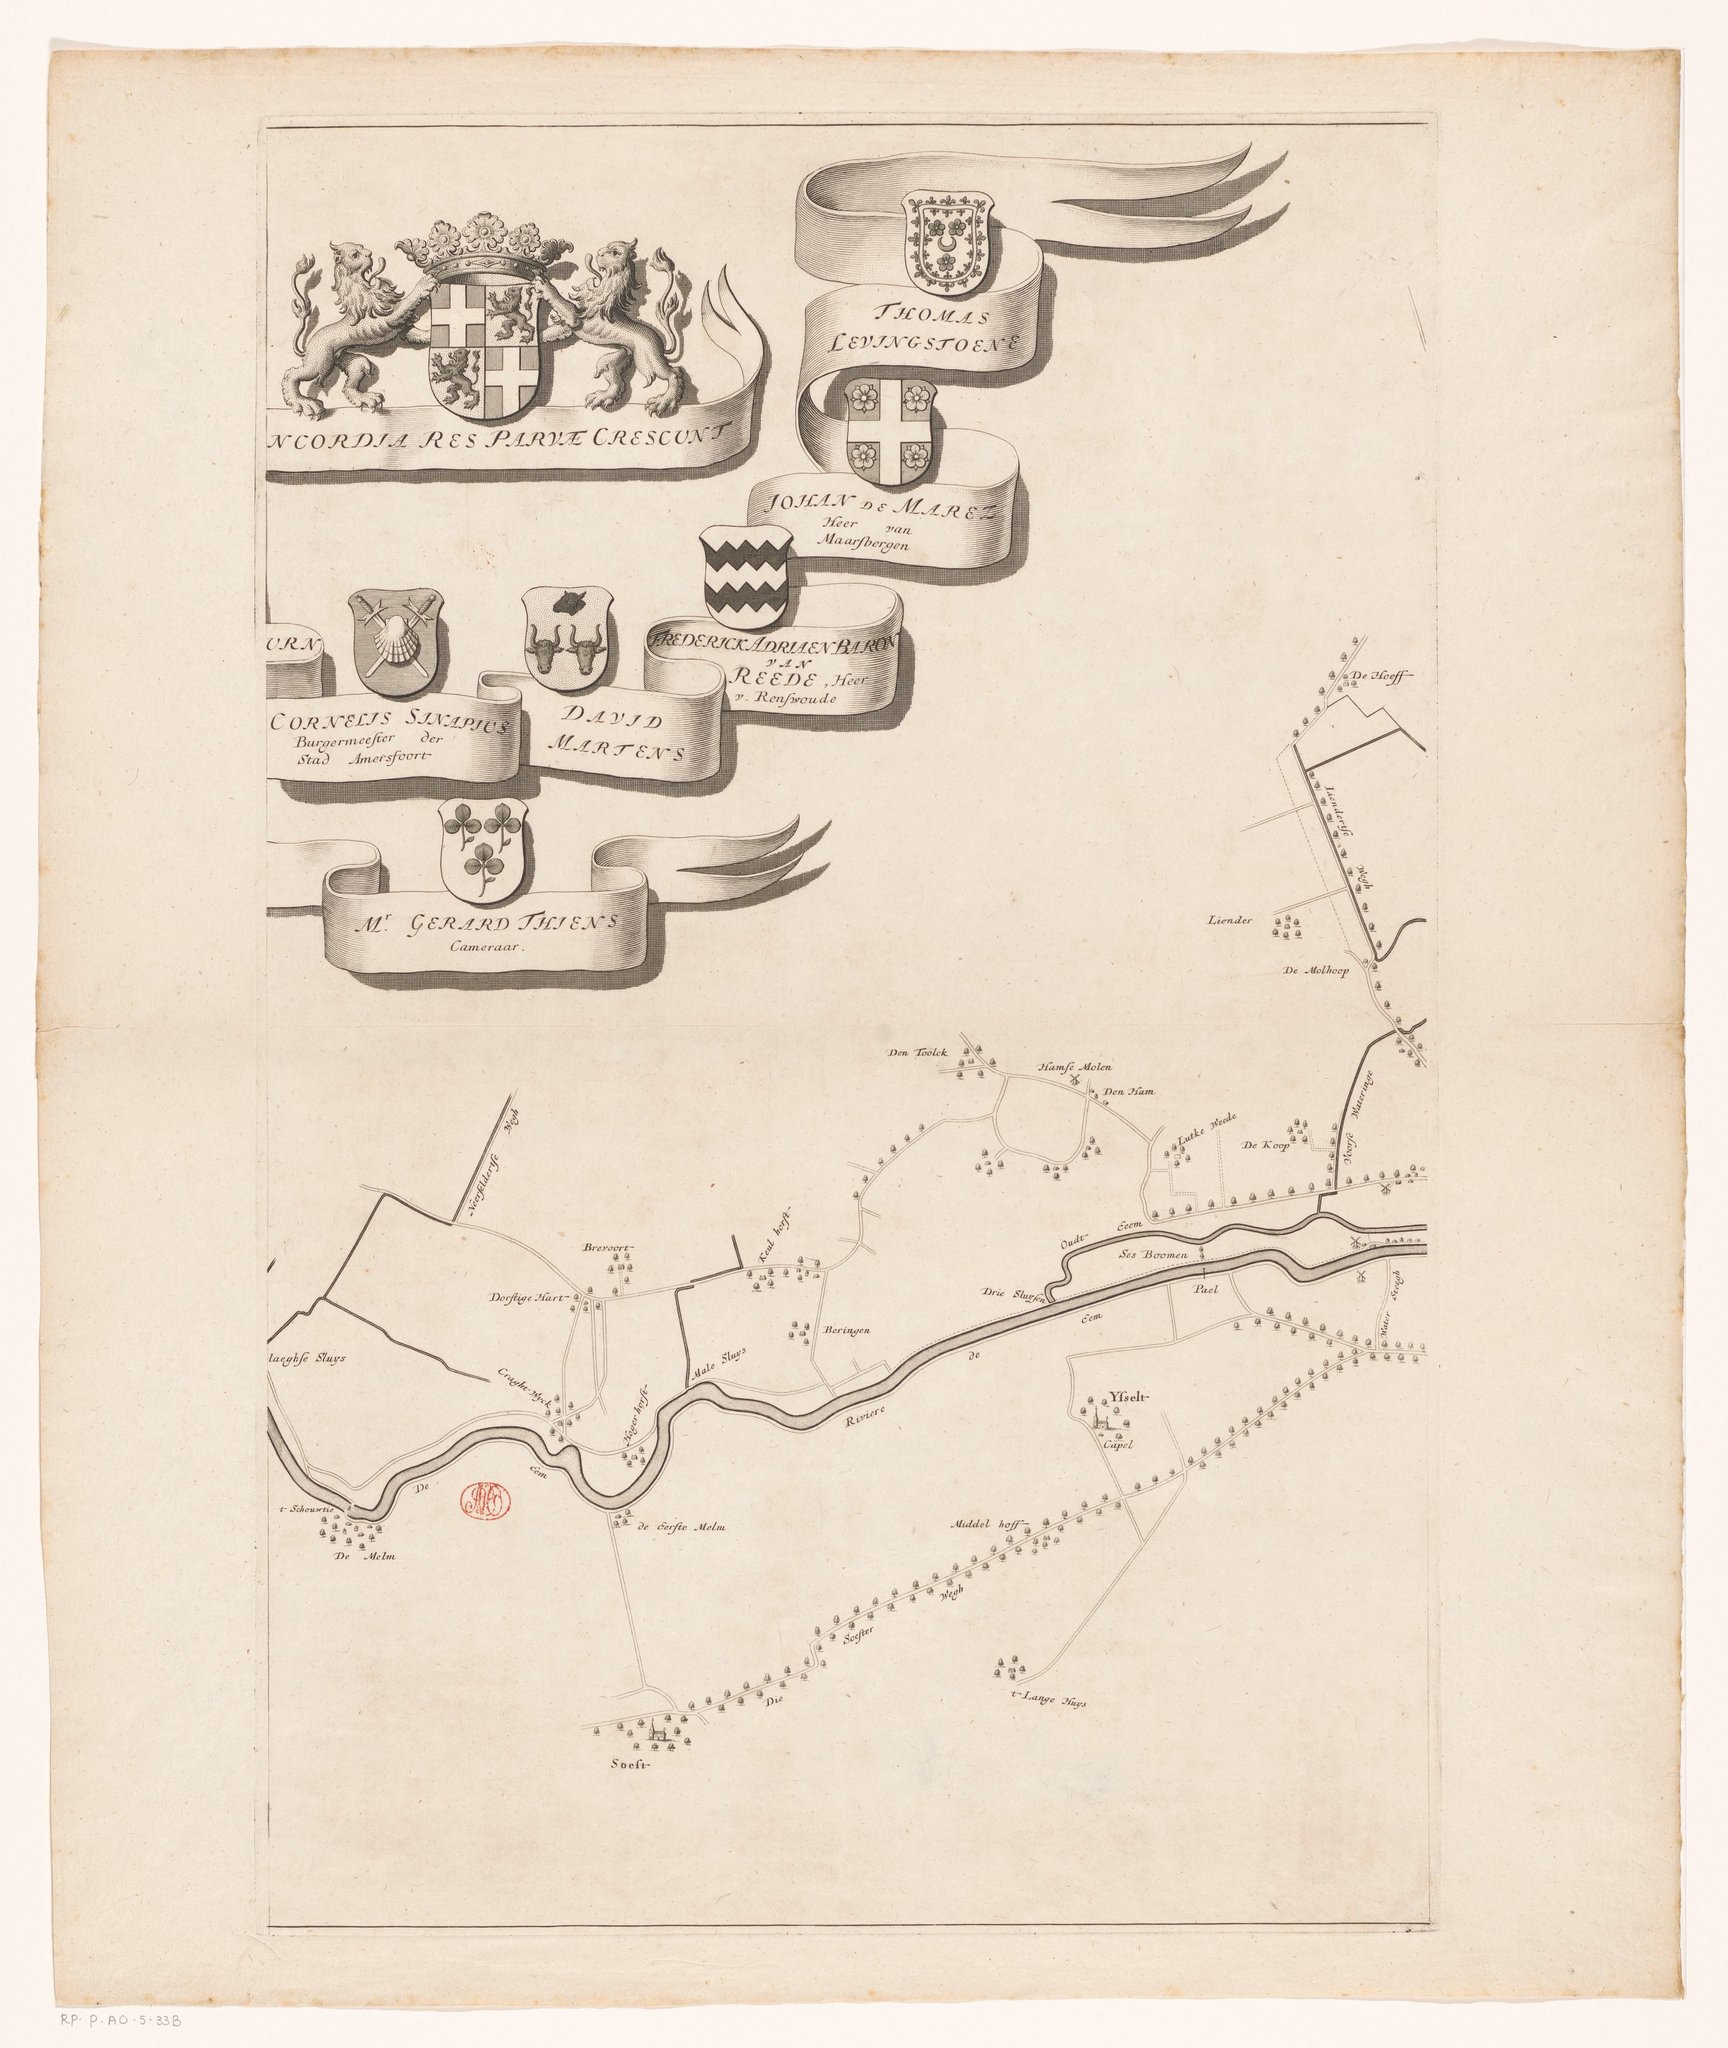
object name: print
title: Kaart van de rivier de Eem (tweede deel)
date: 1692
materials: paper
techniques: engraving, etching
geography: utrecht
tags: coat of arms (as symbol of the state, etc.), maps of separate countries or regions, river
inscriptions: collector's mark: Lugt 195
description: In tegenstelling tot latere beschreven staten komen de namen van de genoemde leden van het College van Watergraaf en Heemraden in de cartouche linksonder overeen met de afgebeelde namen en wapens op de kaart. Hiermee kan het huidige exemplaar gedateerd worden volgens de datering op de kaart: 1692, toen de genoemde personen lid waren van het College.